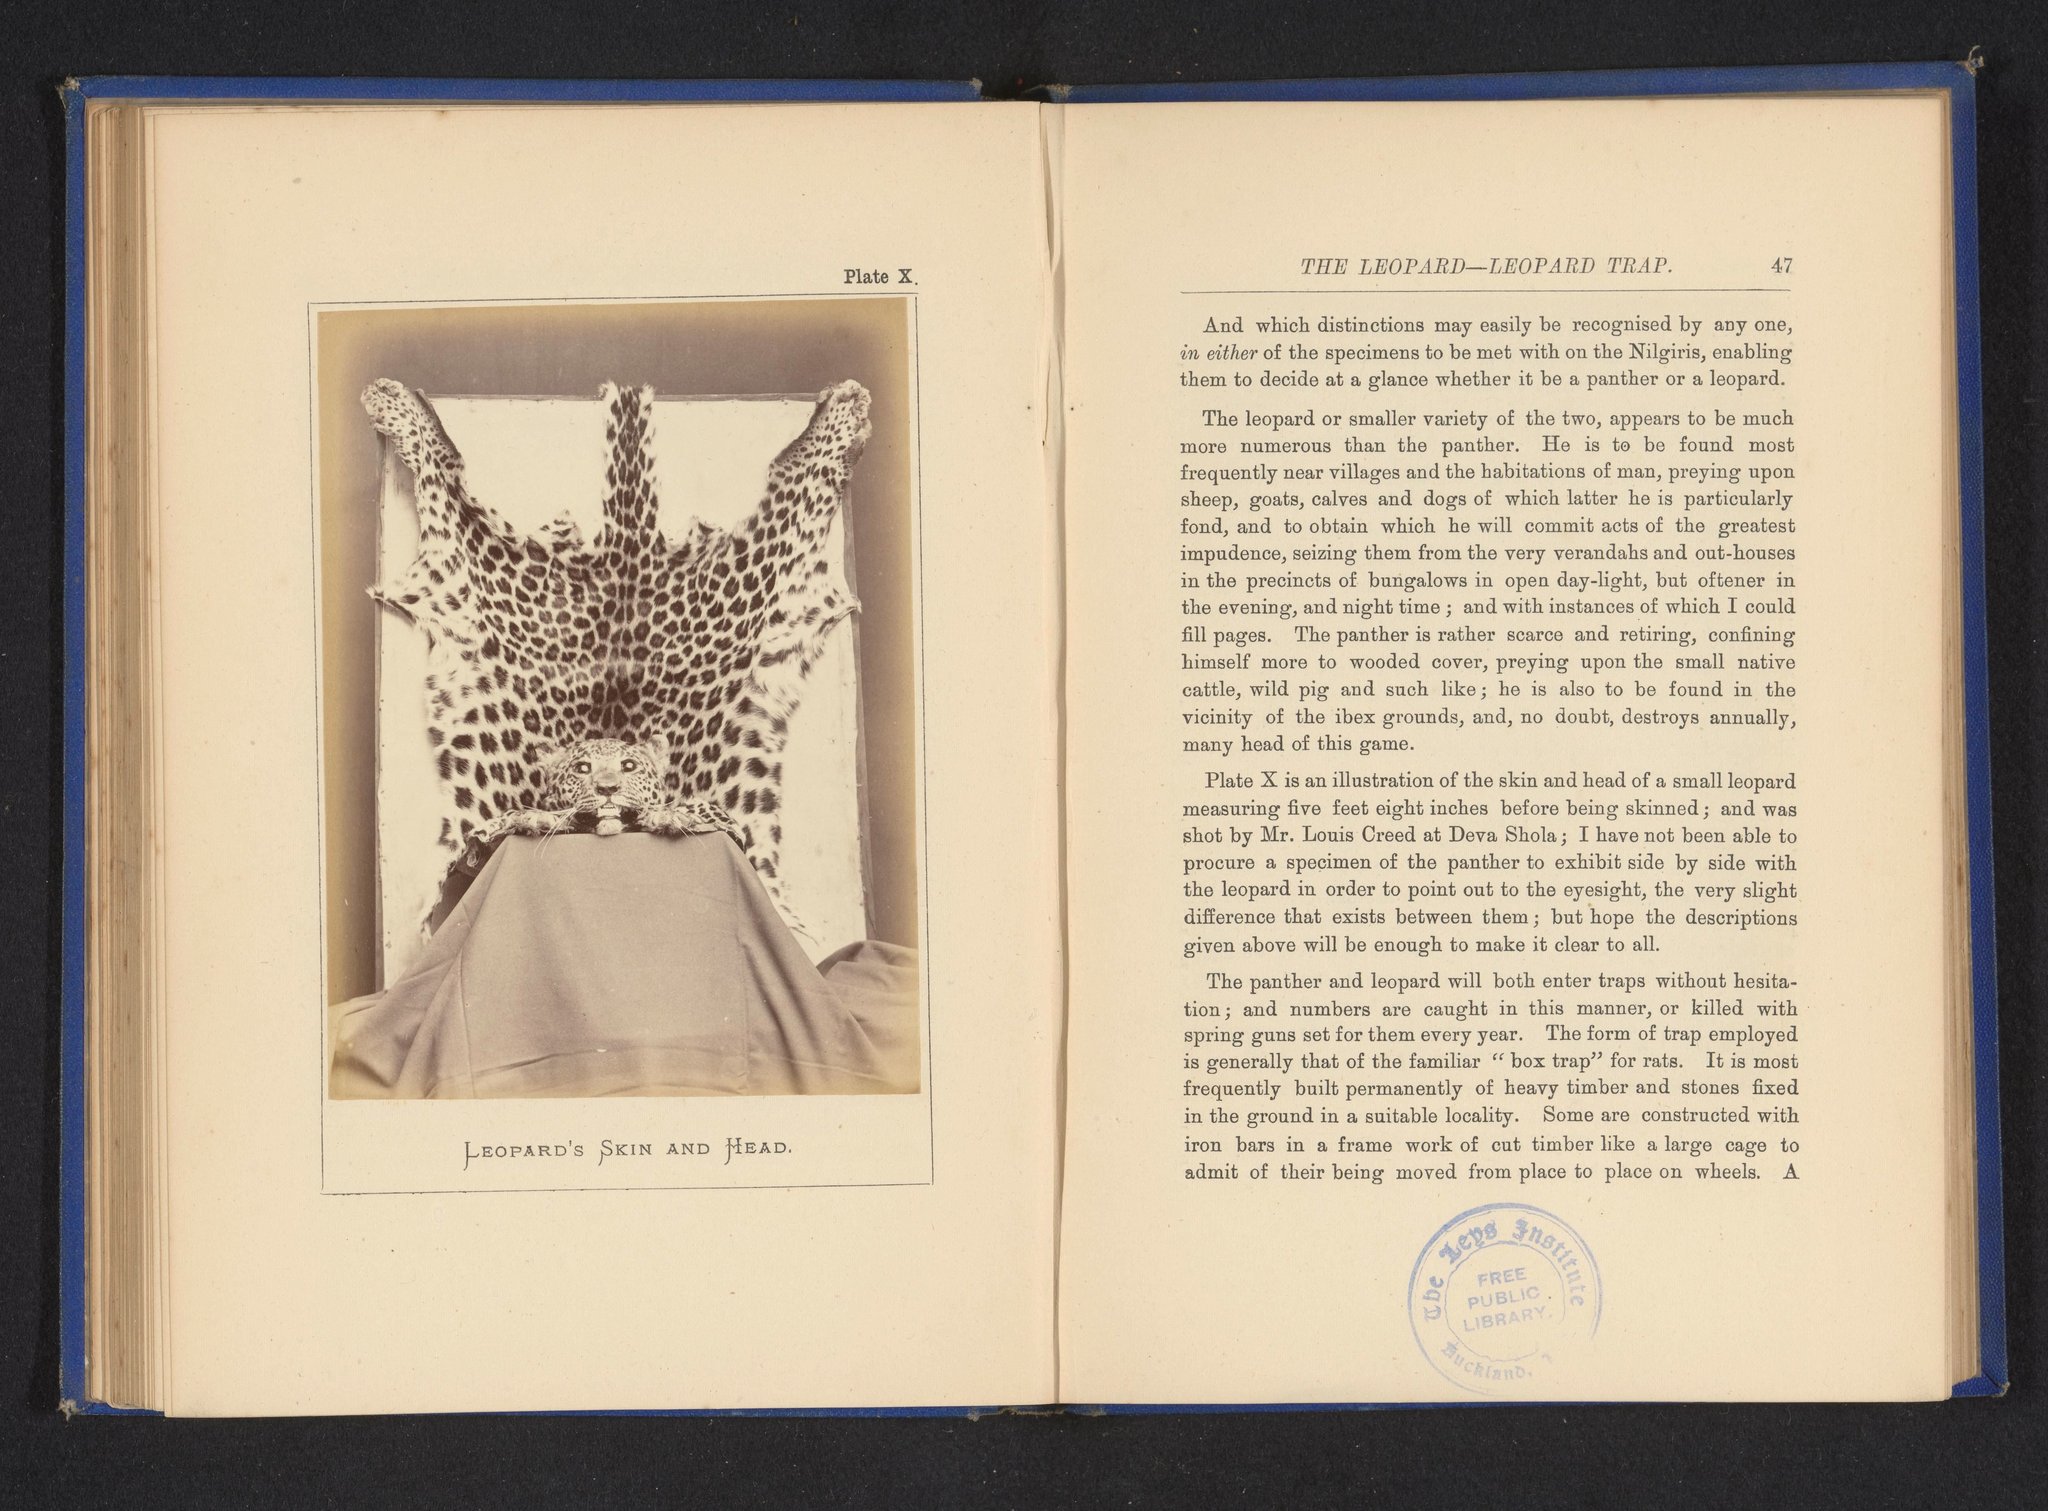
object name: photograph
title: Leopard's skin and head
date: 1870-1880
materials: photographic support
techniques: albumen print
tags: beasts of prey, predatory animals: leopard, hunting trophies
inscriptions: number: ‘Plate X.’